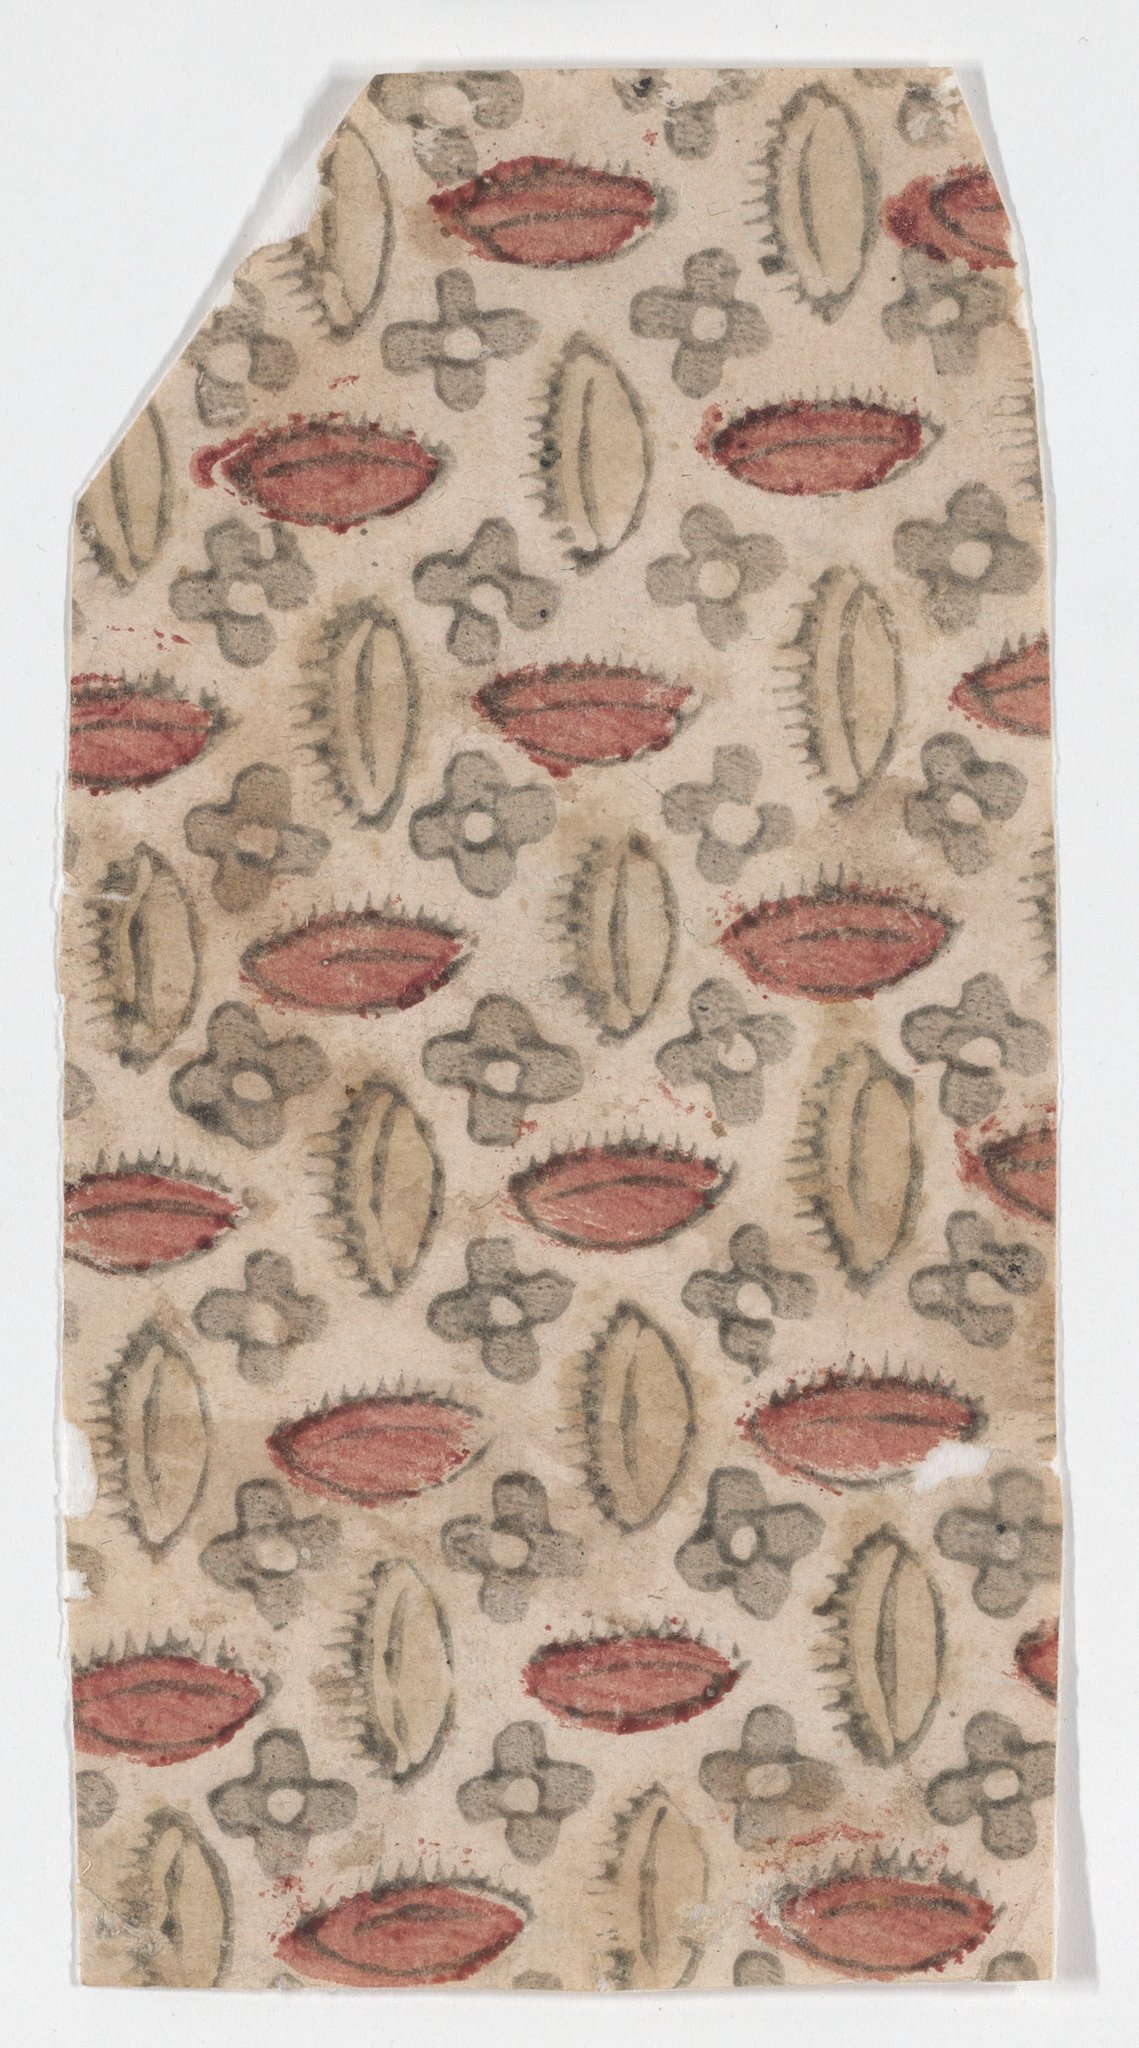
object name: print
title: Sheet with overall pattern of flowers and ovals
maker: Anonymous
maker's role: artist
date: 1801-1900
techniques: relief print